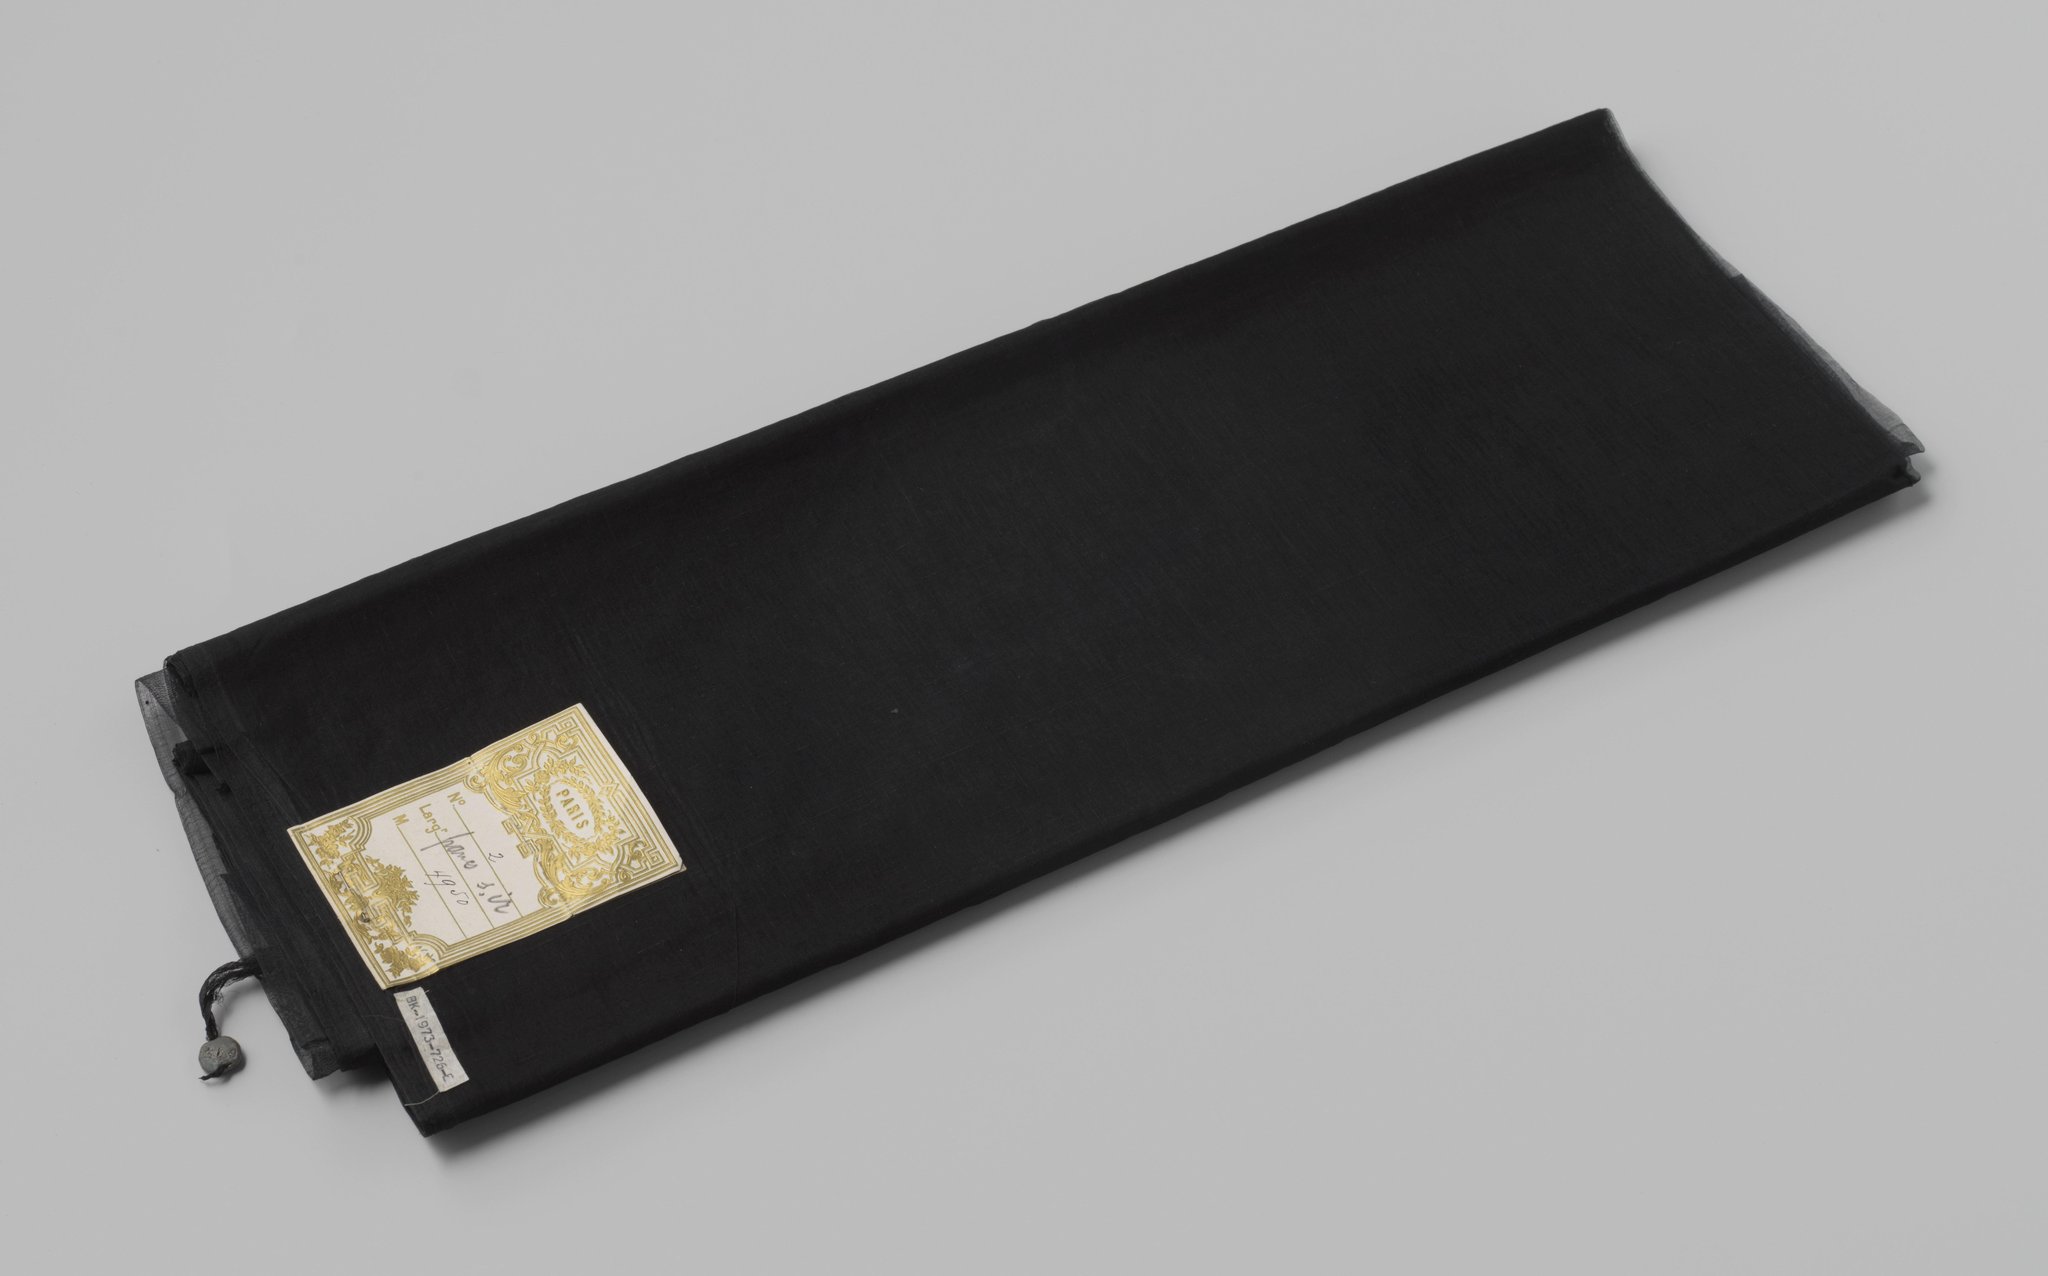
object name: fragment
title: Coupon zwart parasolgaas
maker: gustav schnitzler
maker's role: paraplufabrikant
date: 1900-1925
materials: textile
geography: nijmegen